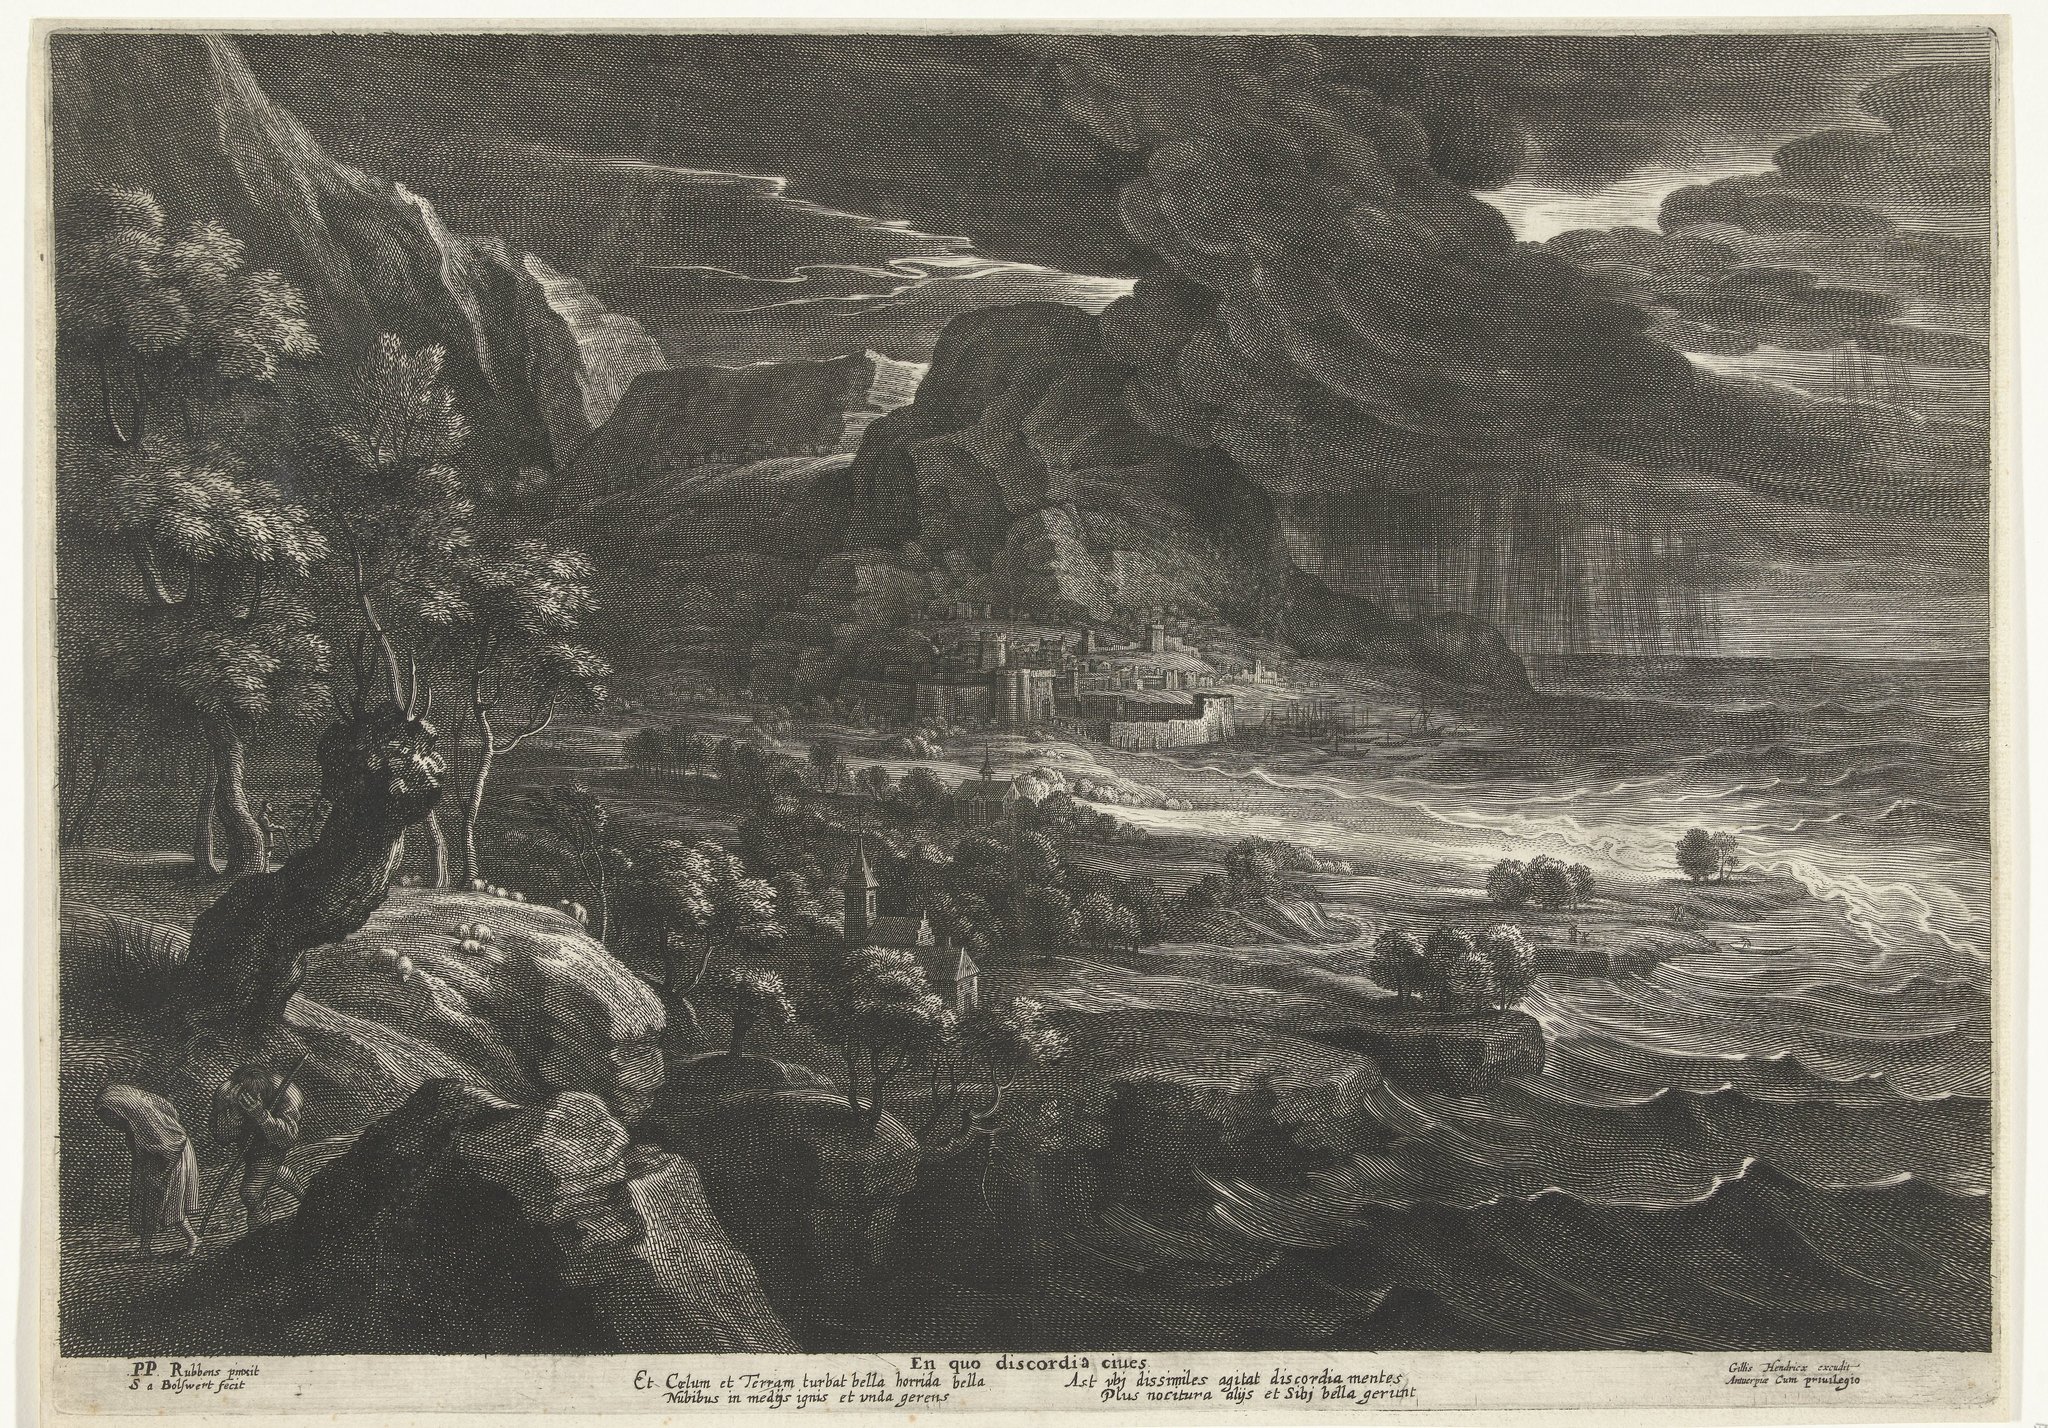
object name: print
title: Landschap aan de kust met onweer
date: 1596-1659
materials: paper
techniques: engraving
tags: thunderstorm, coast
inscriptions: collector's mark: Lugt 240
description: Prent naar schilderij van Peter Paul Rubens. Hollstein beschrijft een serie kleine landschappen onder de nrs. 305 t/m 325 maar deze prenten zijn niet als reeks vervaardigd.